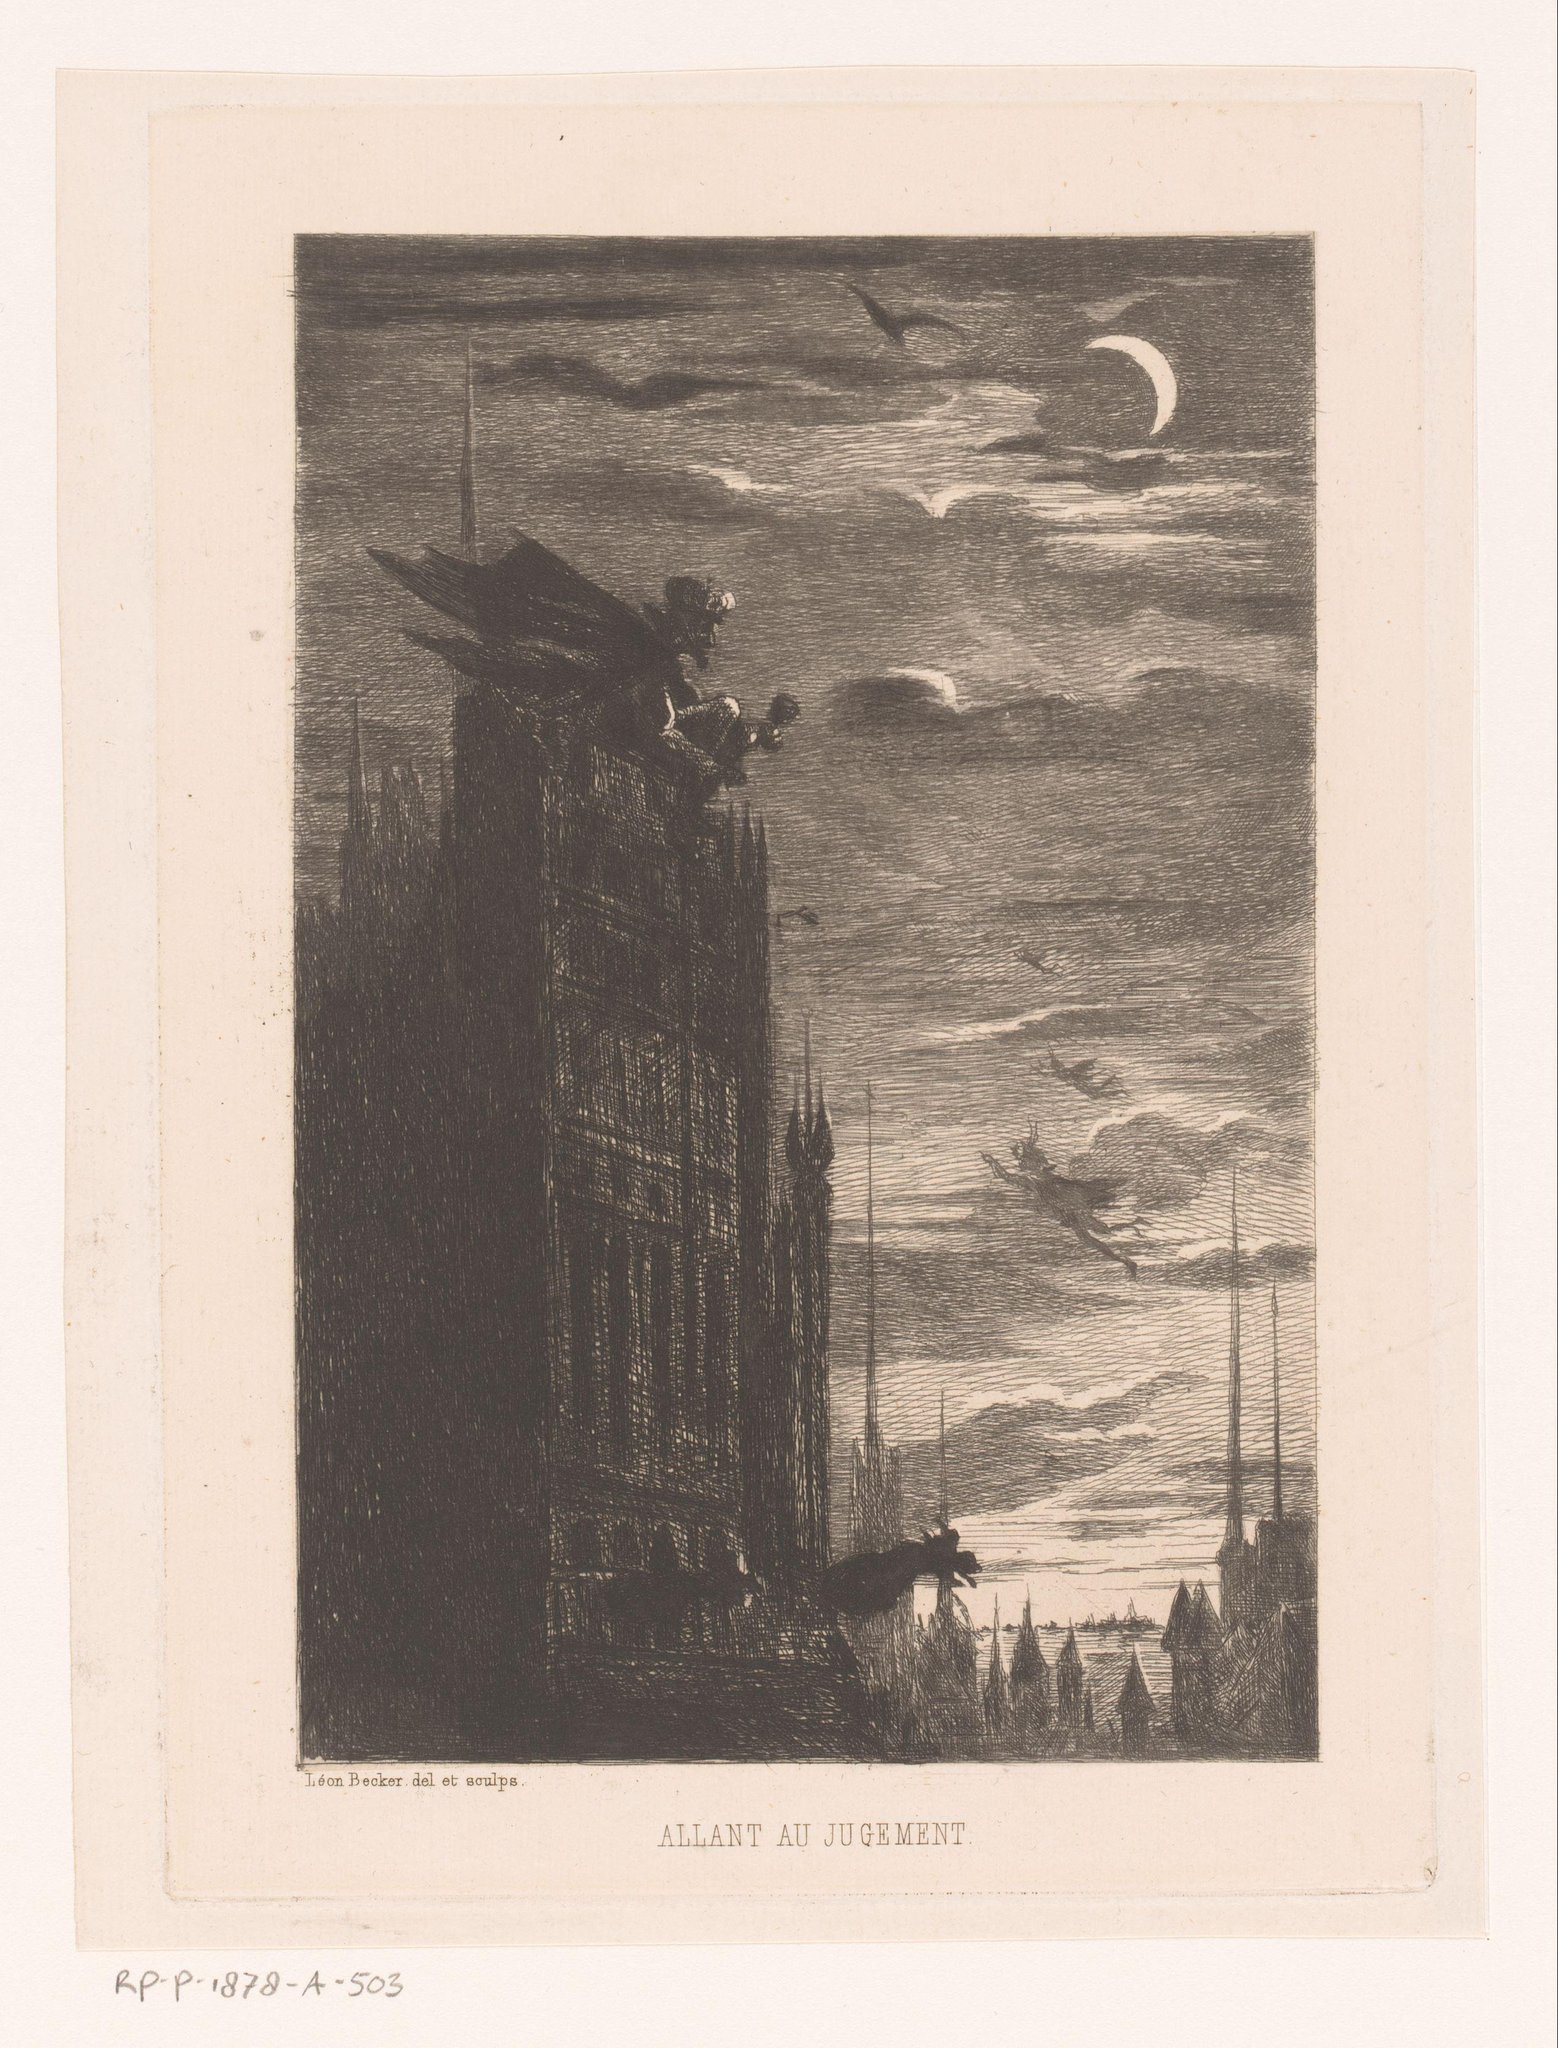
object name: book illustration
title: Nachtgezicht met kerktoren en duivels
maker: léon becker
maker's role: print maker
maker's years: 1826-1909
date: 1869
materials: paper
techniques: etching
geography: paris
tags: devil(s) and demons, parts of church exterior and annexes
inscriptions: collector's mark: Lugt 2228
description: Prent uit: Coster, Charles de. La légende et les aventures héroiques, joyeuses et glorieuses d'Ulenspiegel et de Lamme Goedzak au pays de Flandres et ailleurs. Parijs: Librairie Internationale, 1869.